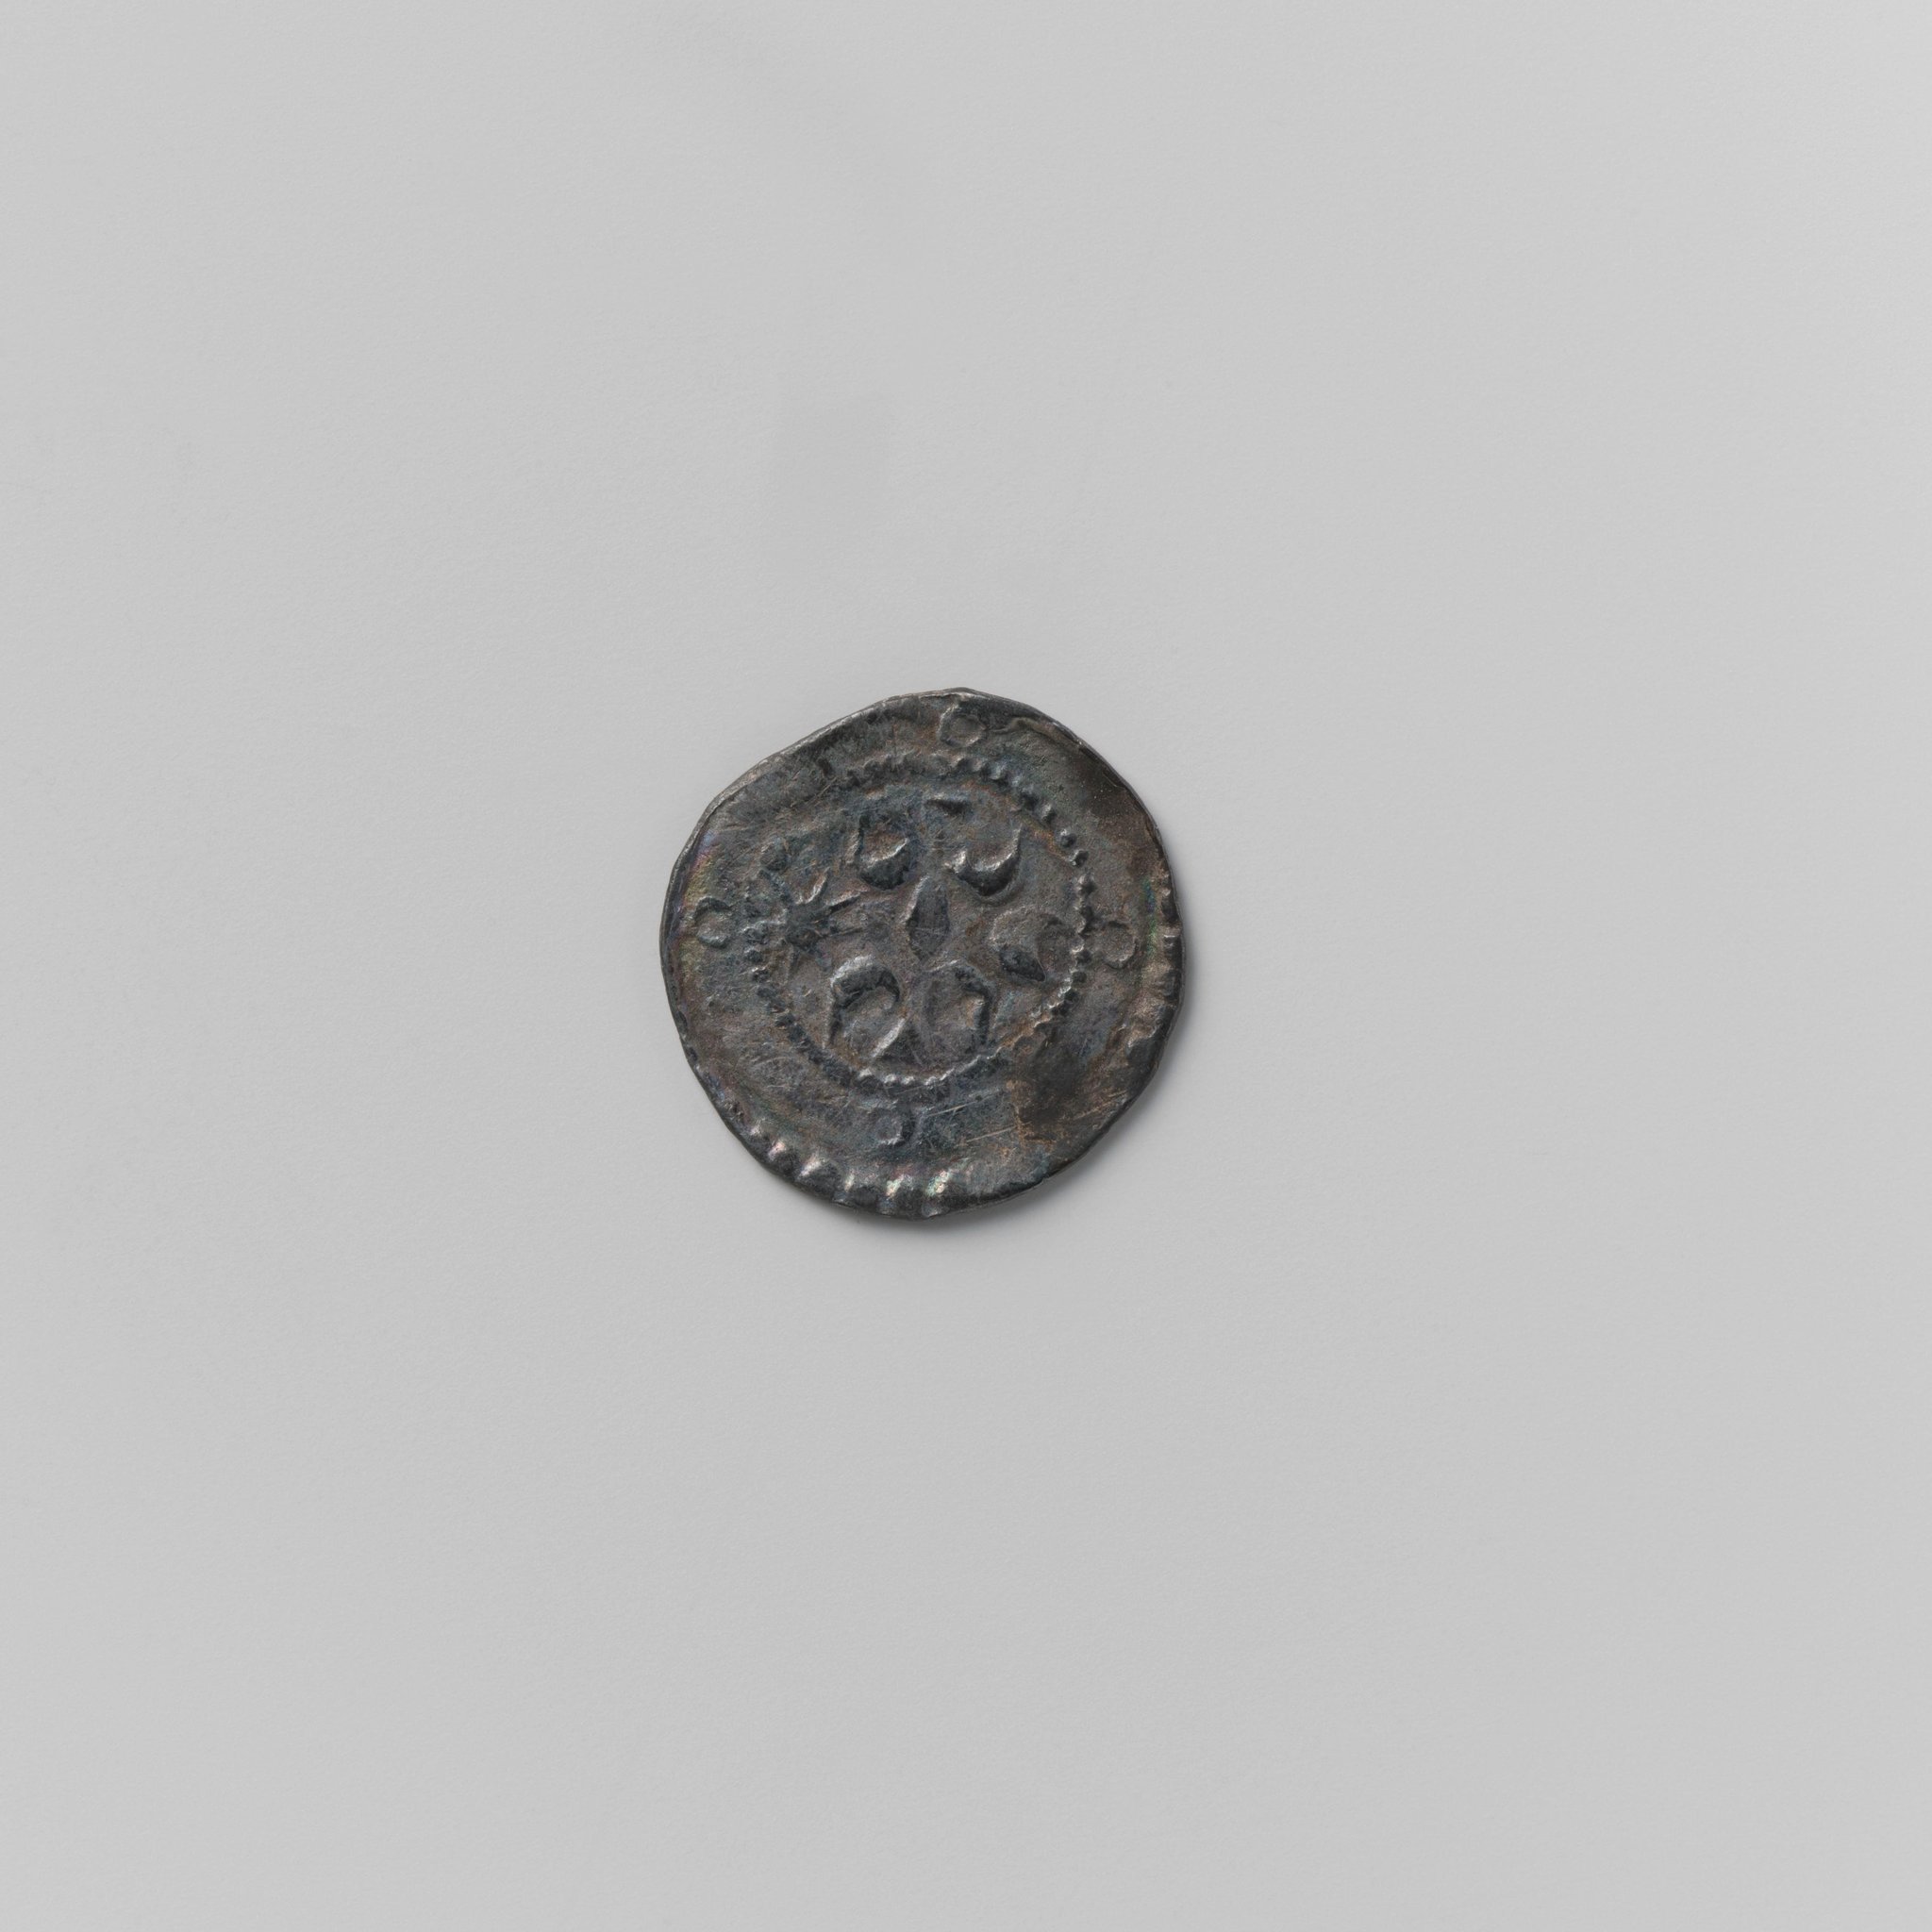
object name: penny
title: Penning uit Vlaanderen op naam van muntmeester Simon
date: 1100-1200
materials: silver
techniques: striking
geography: ghent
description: Voorzijde: twee naar elkaar gewende lelies, links daarvan ster, rechts daarvan maansikkel. Op rand vier cirkeltjes. Keerzijde: kort gevoet kruis, in hoeken versiering. Omschrift: Simoni